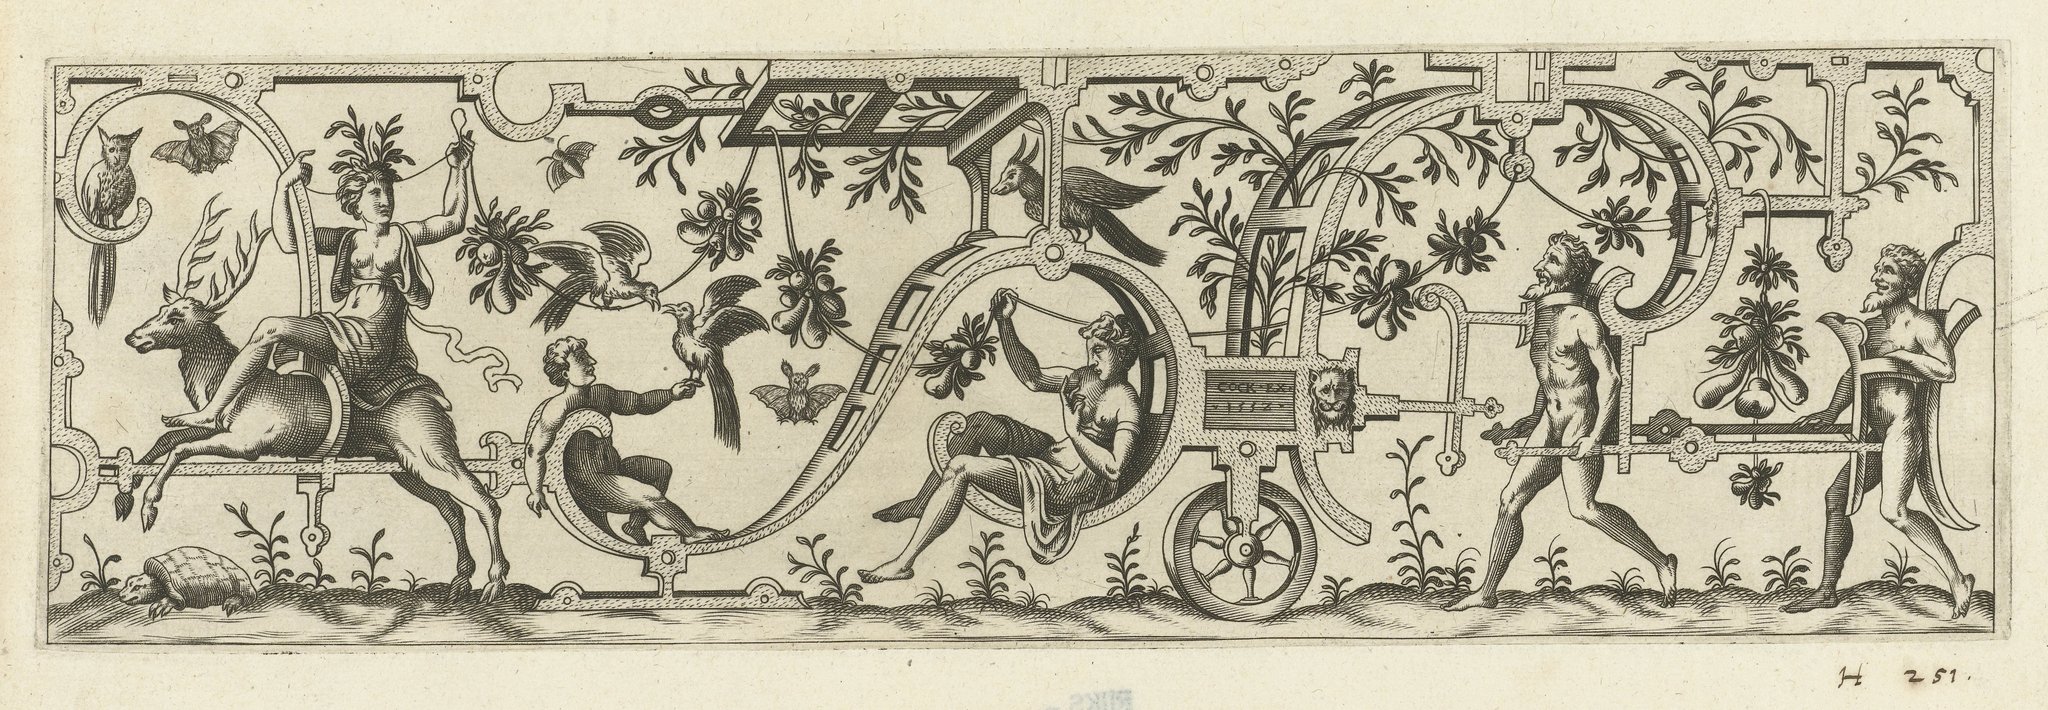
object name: print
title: Kruisiging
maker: hendrick goltzius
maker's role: draughtsman, painter, print maker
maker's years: 1558-1617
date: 1585-1600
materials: paper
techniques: engraving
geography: haarlem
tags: crucified christ with mary, john, and mary magdalene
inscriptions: collector's mark: Lugt 240, signature: ‘HGoltzius fecit’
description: Onvoltooide prent van de kruisiging van Christus. Gedeeltelijk voltooid is de figuur van Johannes, op de rug gezien. Op de achtergrond zijn de contourlijnen te zien van de drie kruizen en de drie Maria's.